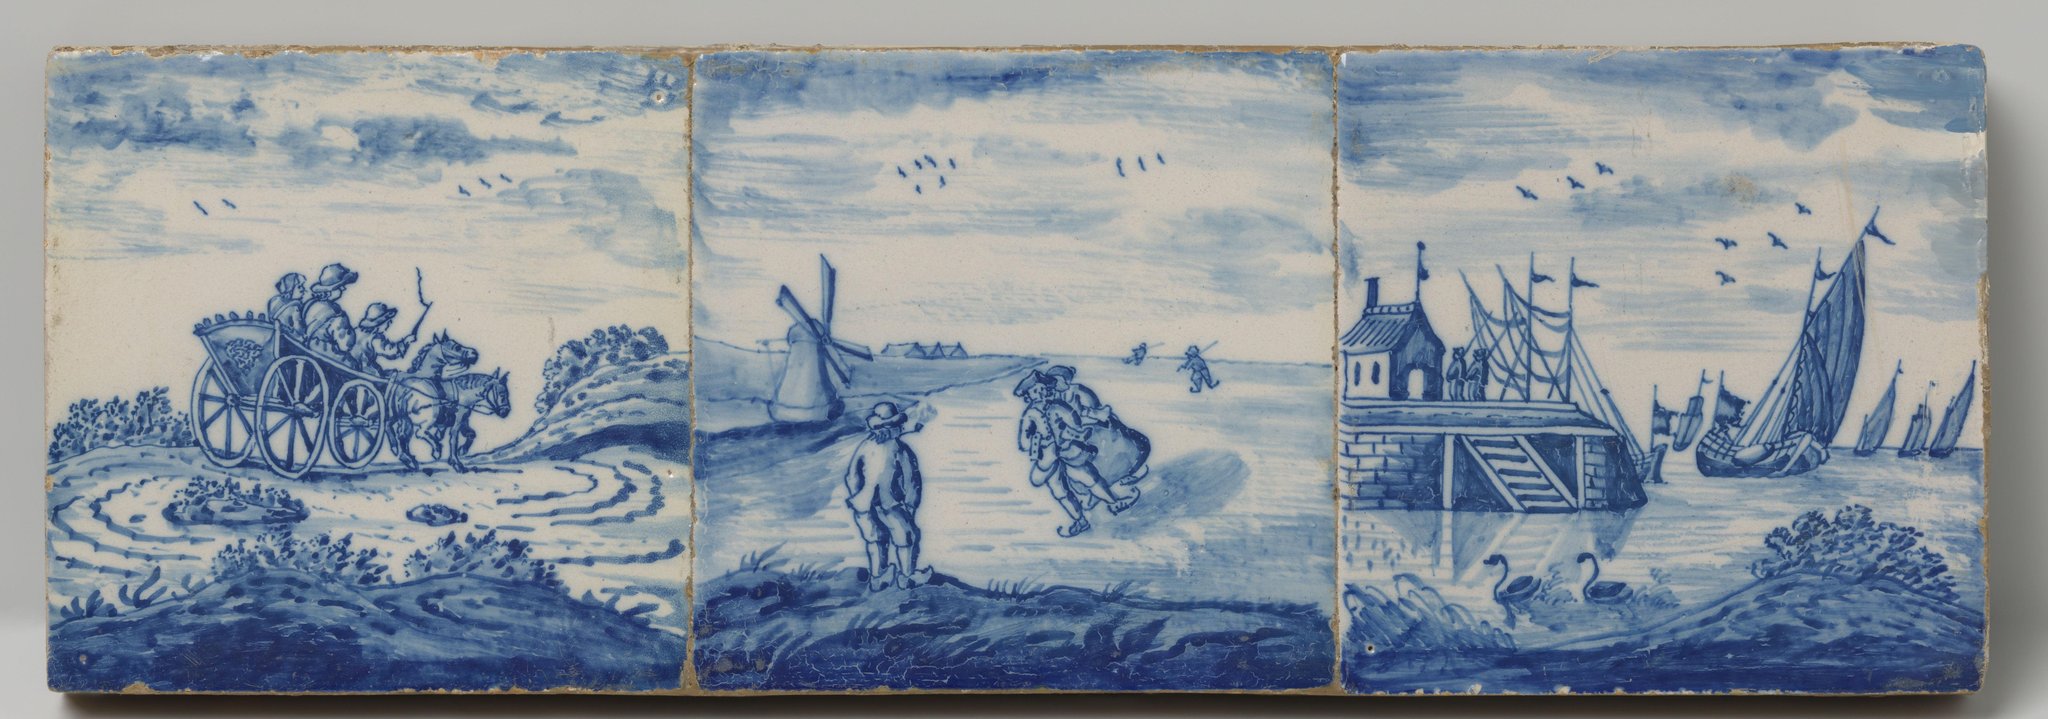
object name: tegelveld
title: Veld van drie genretegels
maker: Anonymous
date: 1700-1750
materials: earthenware, glaze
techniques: maiolica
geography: amsterdam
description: Veld van drie tegels (1 x 3) elk met een blauw geschilderd landschap met figuren.